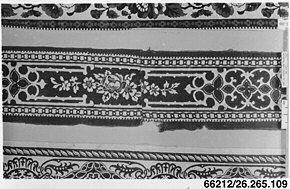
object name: border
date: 1801-1833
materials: cotton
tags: flowers